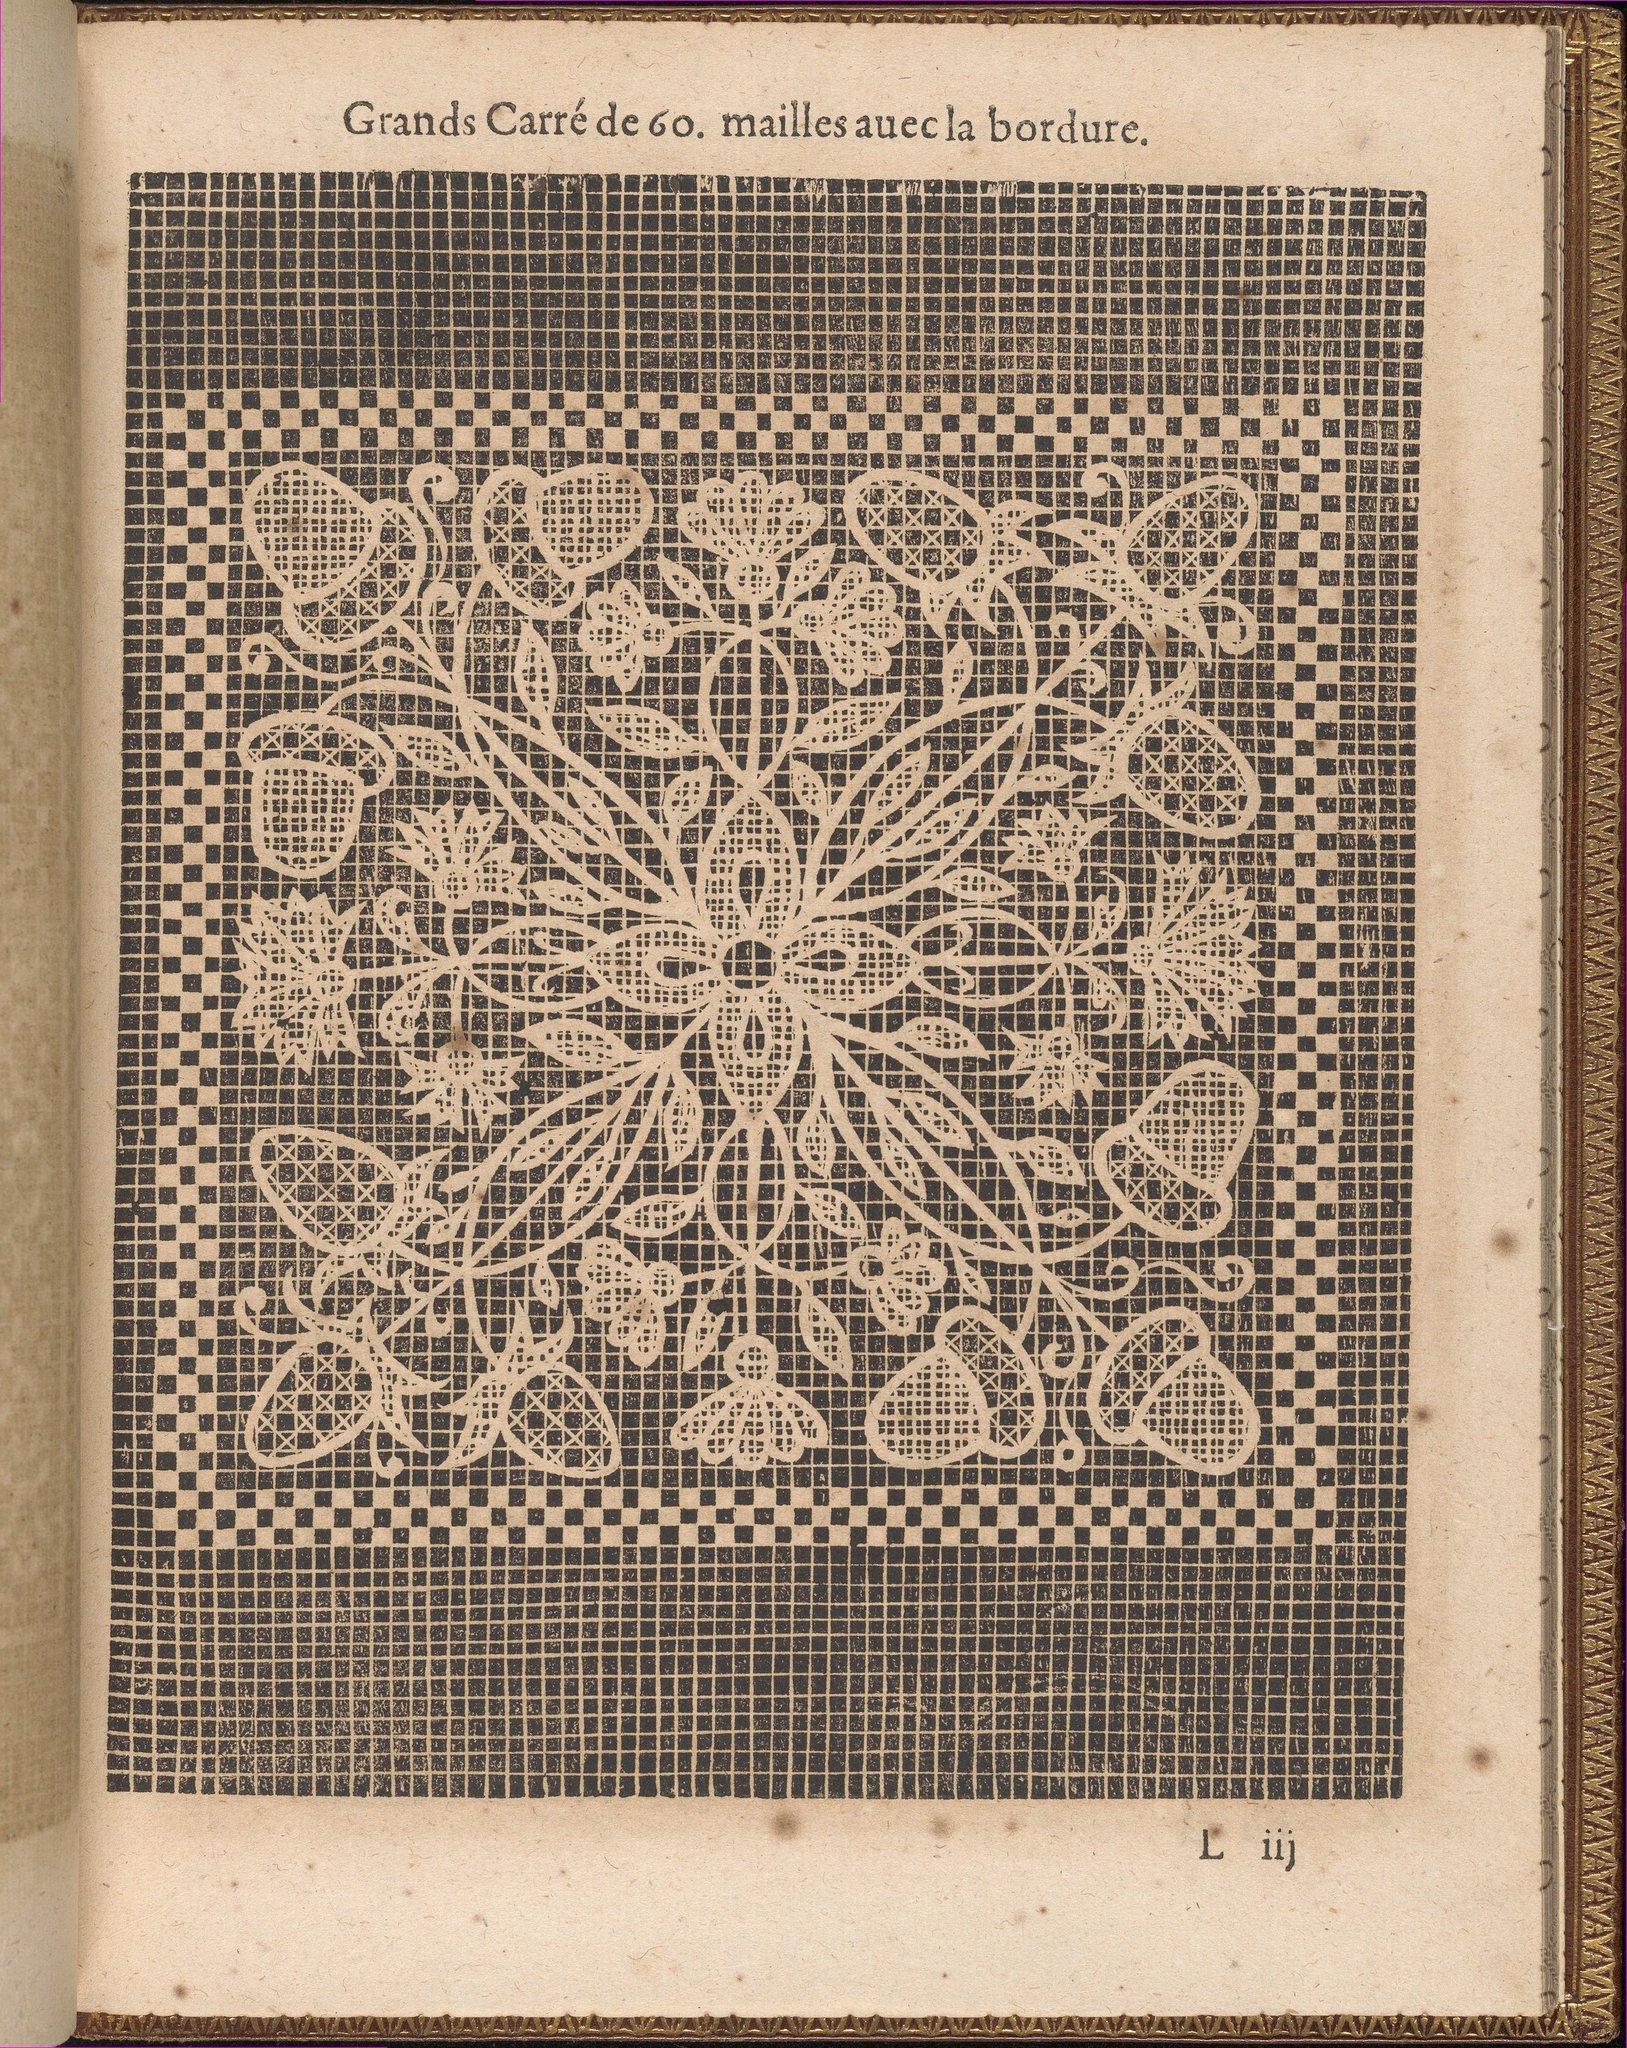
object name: book print ornament architecture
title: La Pratique de l'Aiguille, page 42 (recto)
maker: matthias mignerak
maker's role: author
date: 1605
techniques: woodcut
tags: ornament,acorns